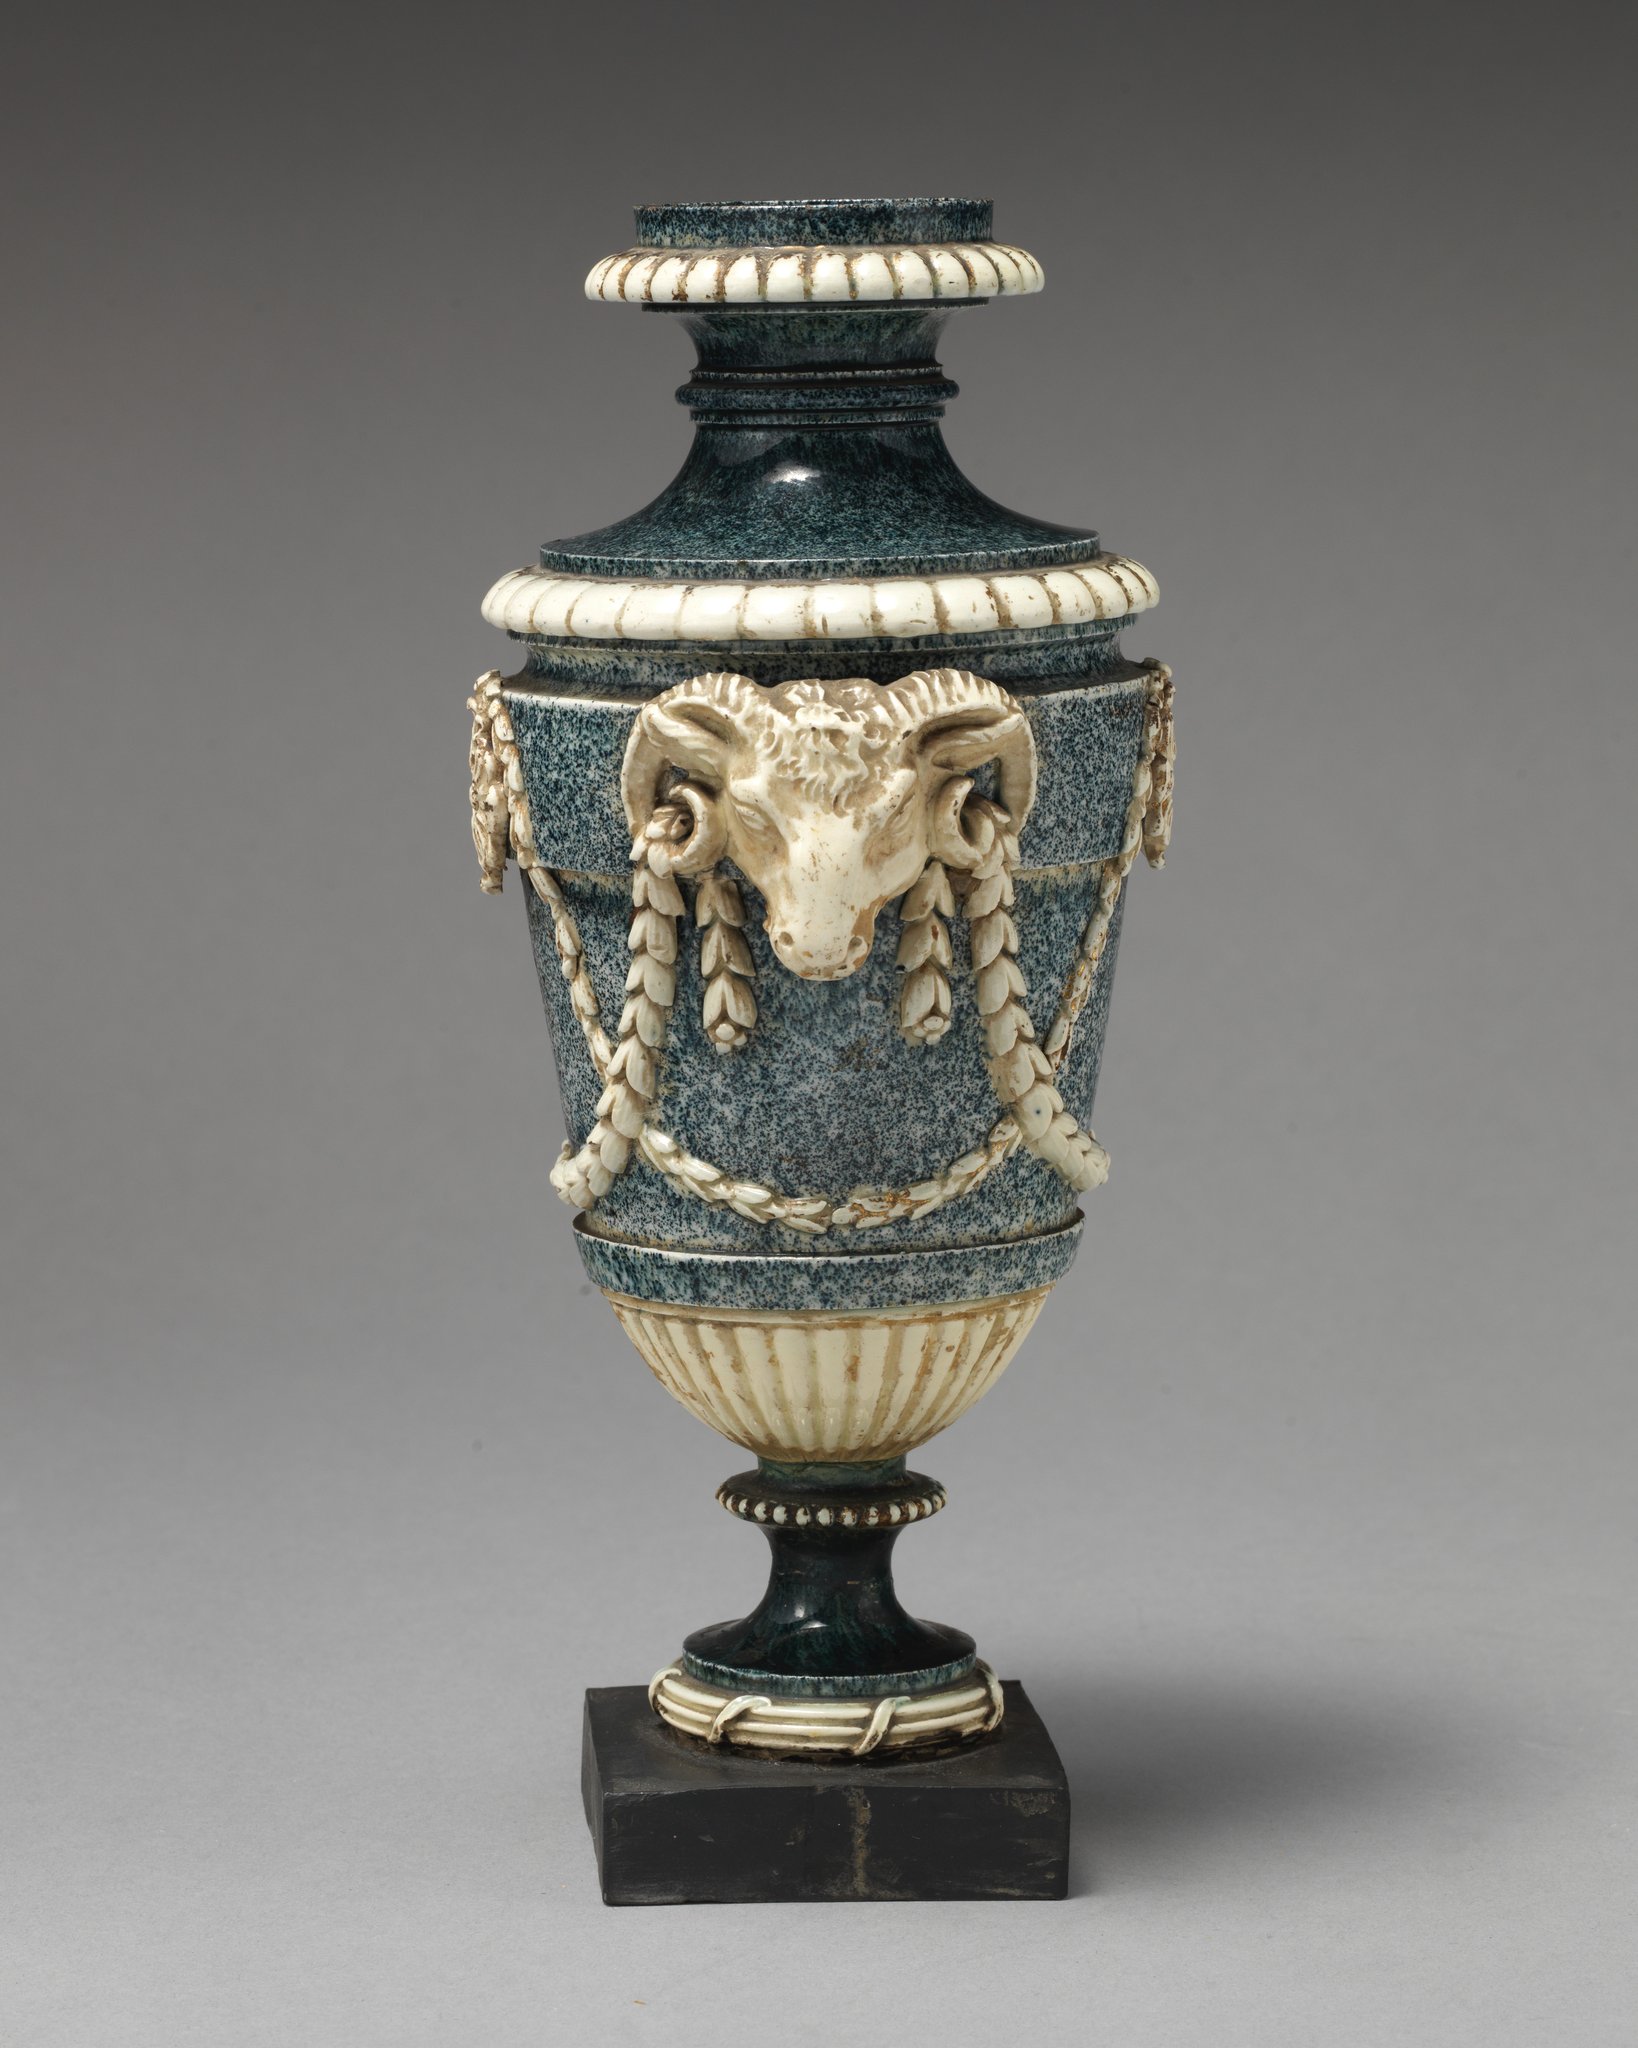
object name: vase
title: Vase (one of a pair)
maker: humphrey palmer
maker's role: maker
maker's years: 1760-1778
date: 1767-1800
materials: pottery